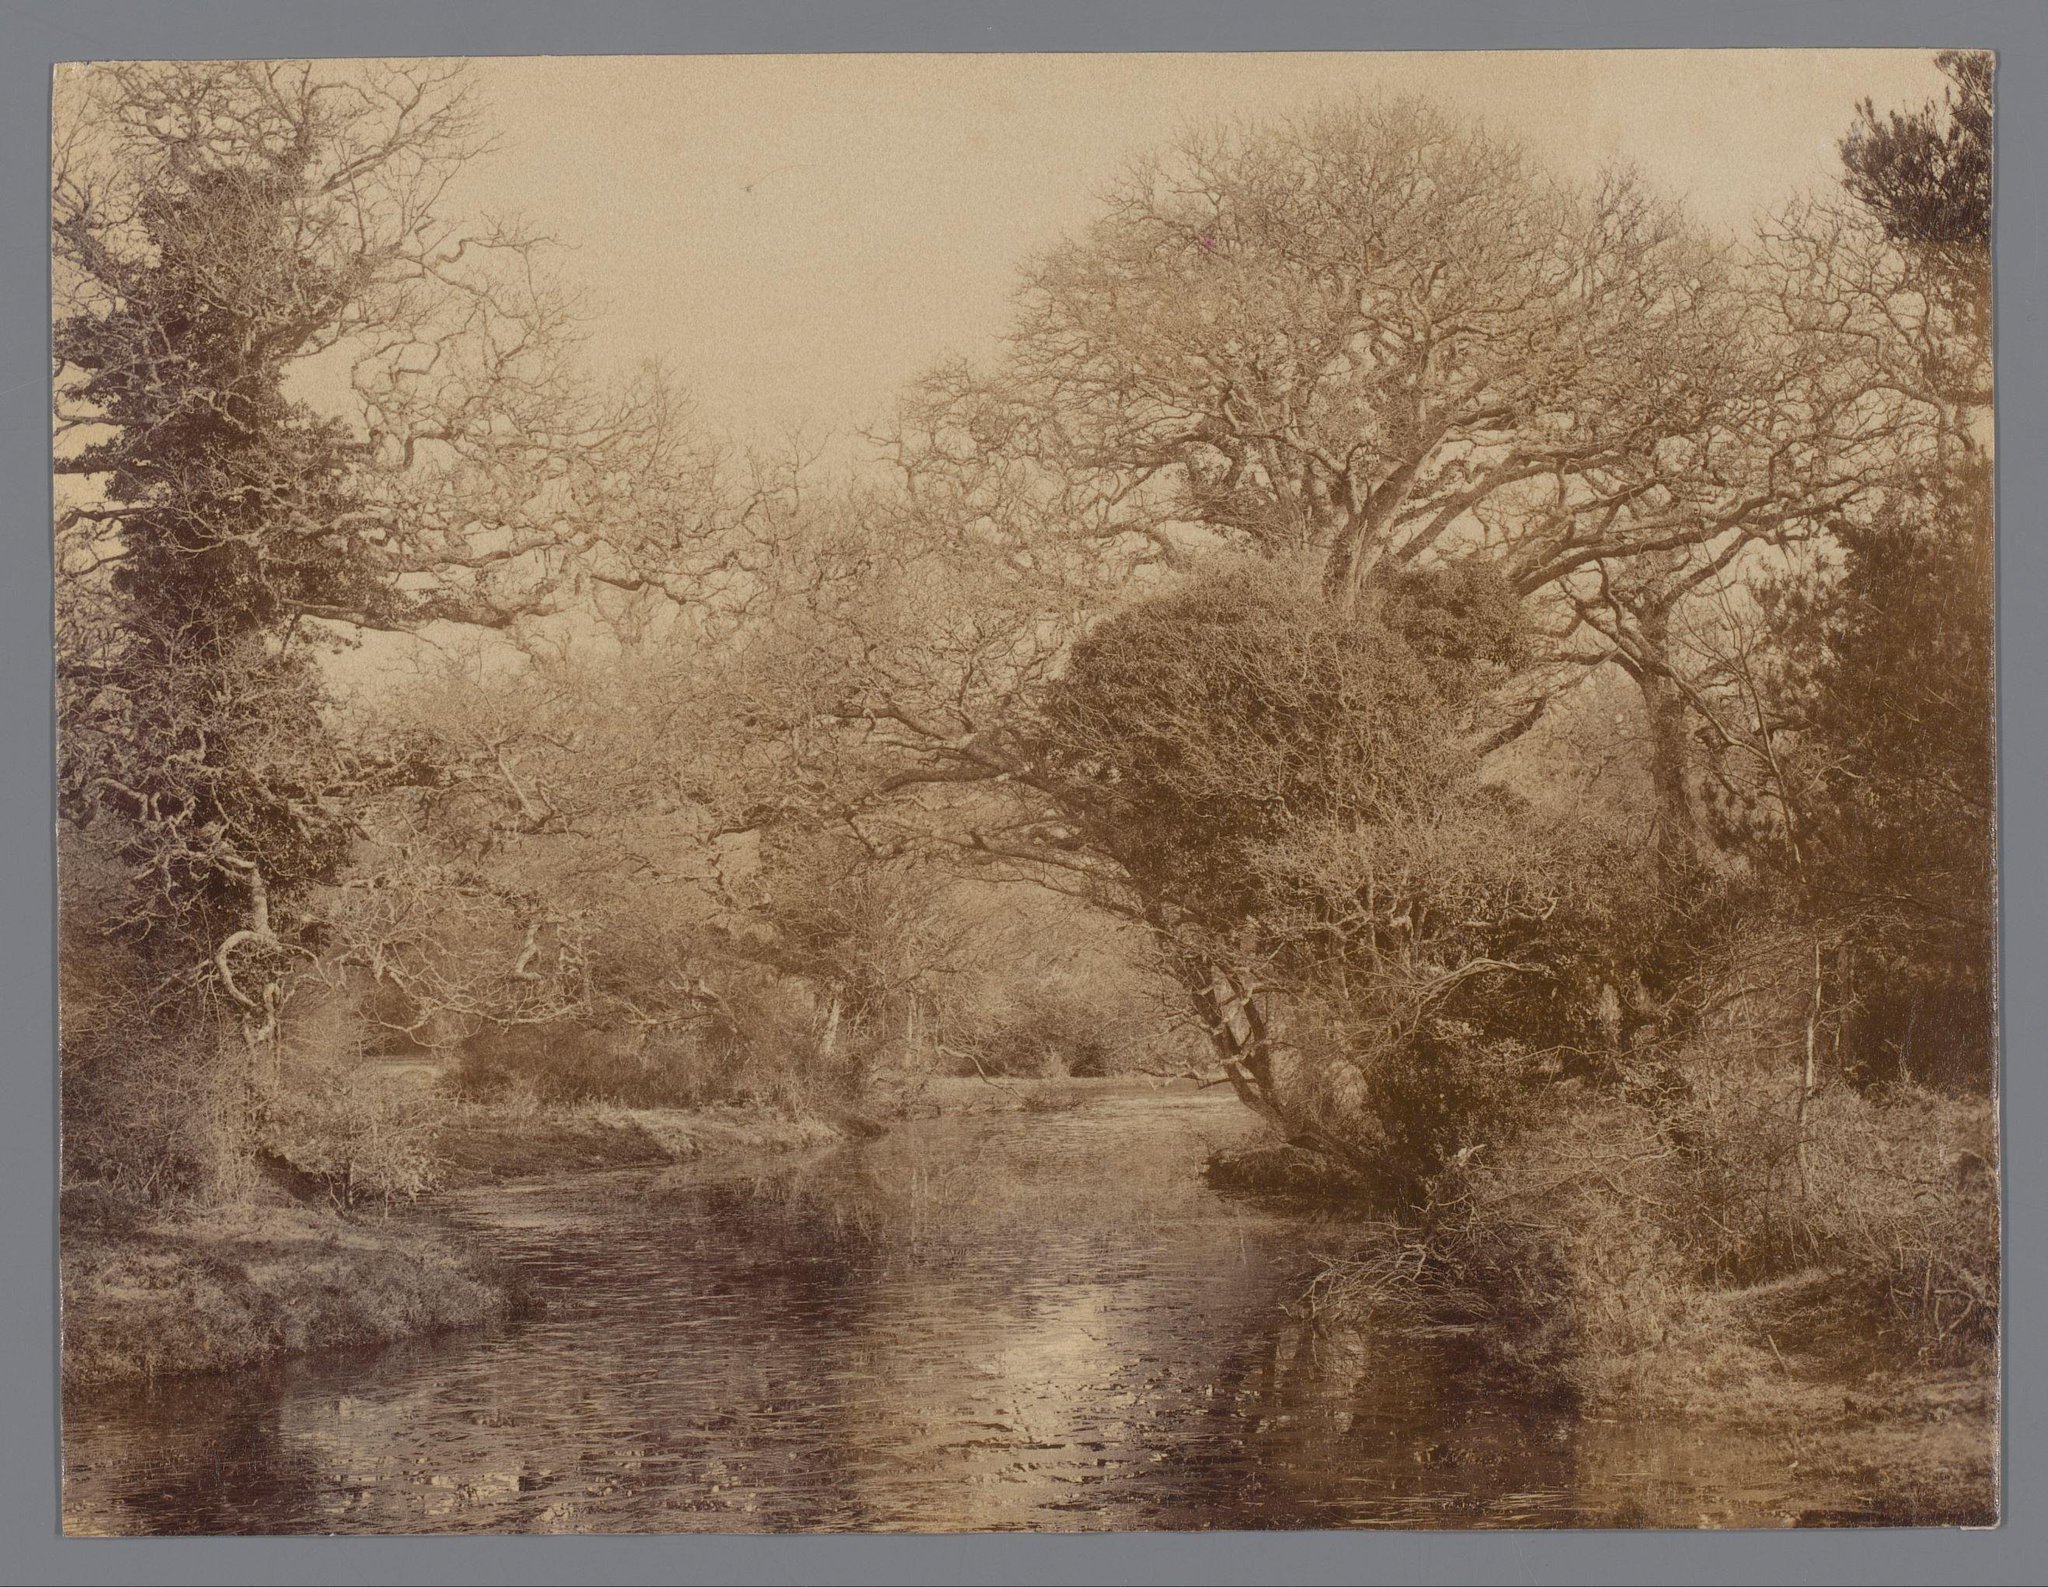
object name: photograph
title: Landschap met rivier en bomen aan weerszijden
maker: Anonymous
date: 1870-1890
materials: paper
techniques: albumen print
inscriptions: inscription: ‘by a Sh [...?] Rd’, inscription: ‘b b’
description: Landschap met rivier en bomen aan weerszijden.